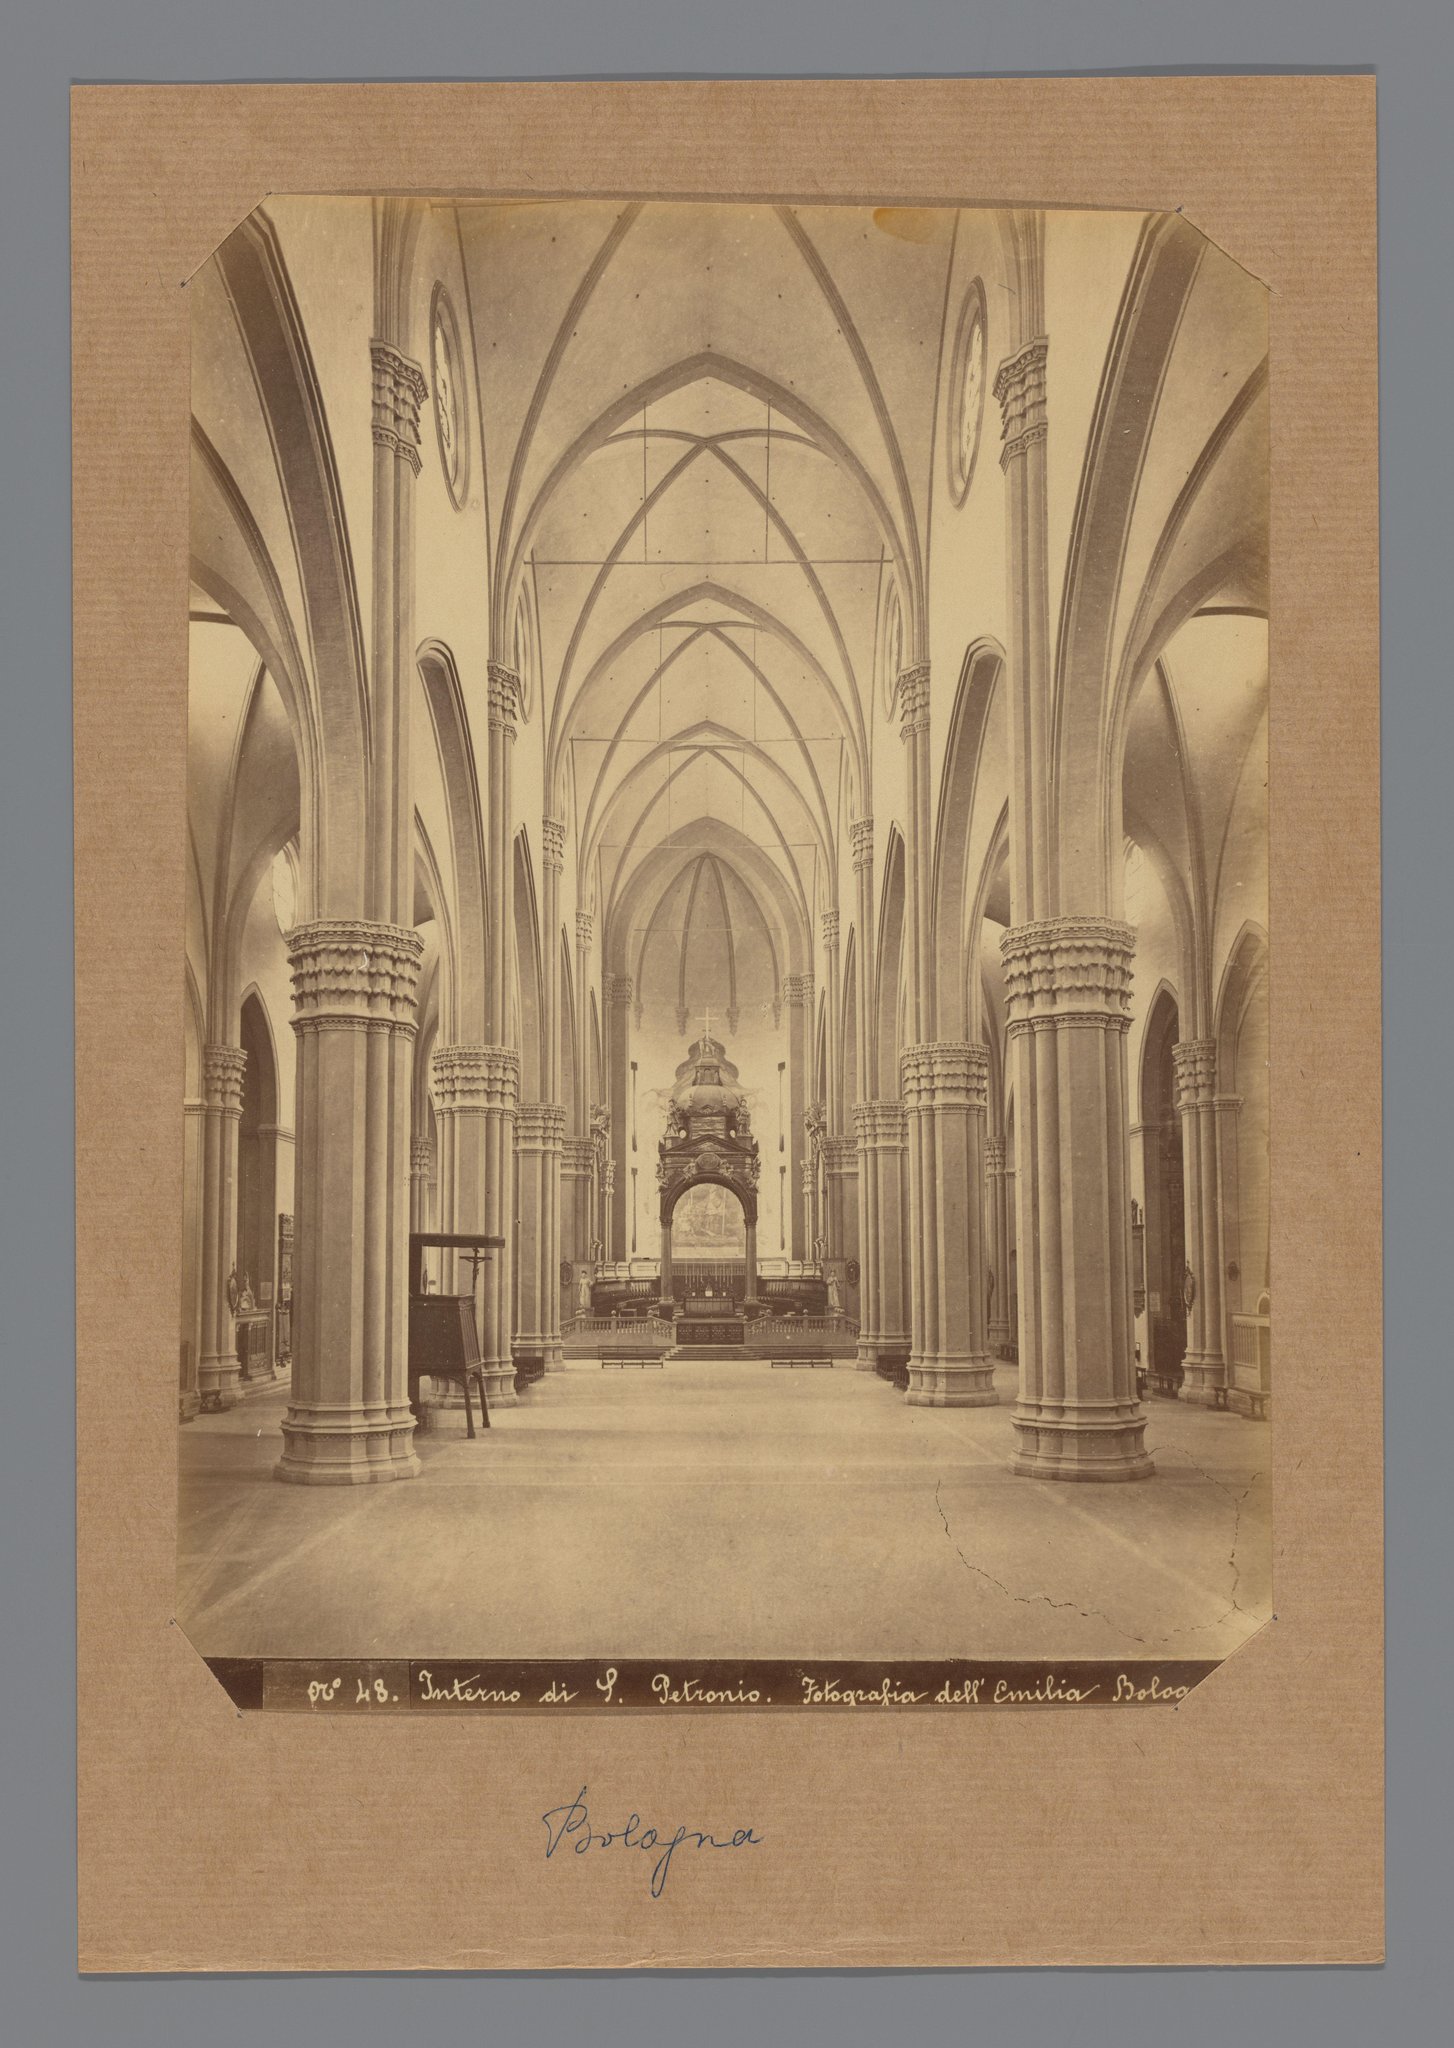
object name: photograph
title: Italië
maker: Anonymous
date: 1880-1910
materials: photographic support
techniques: albumen print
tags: italy